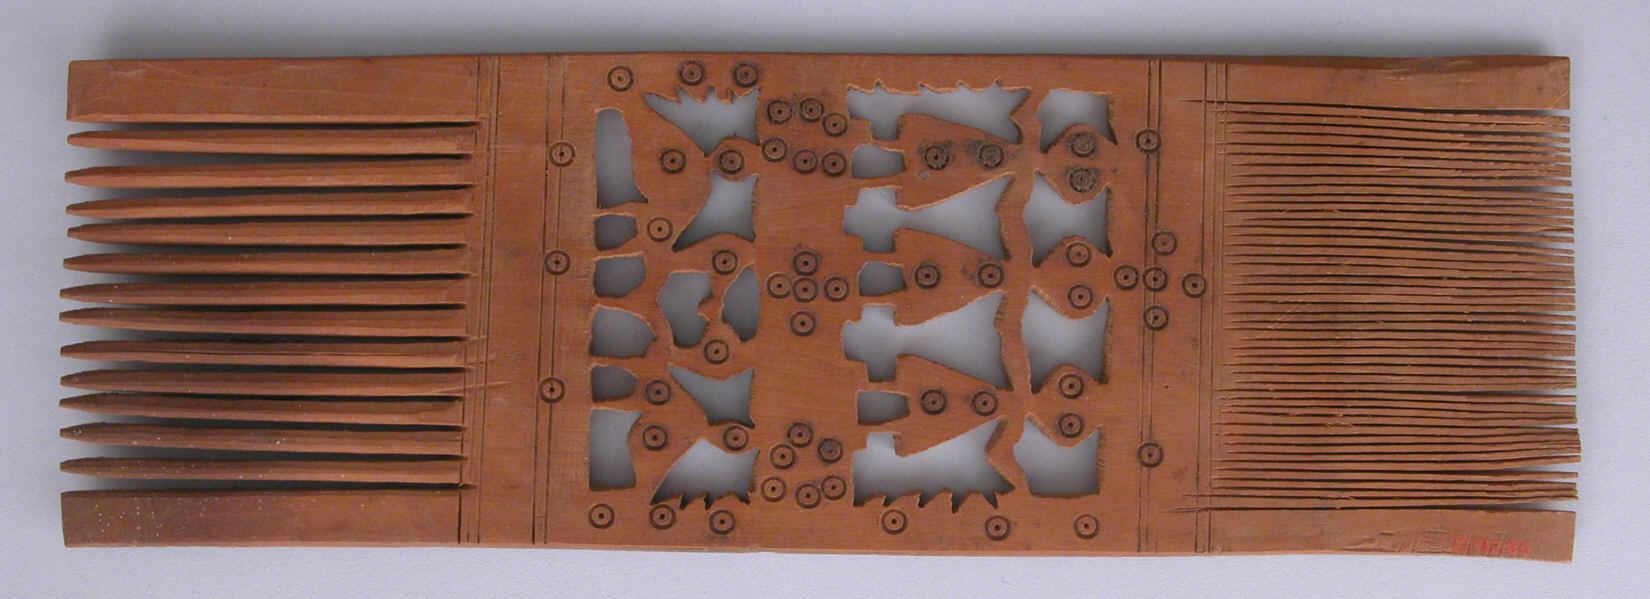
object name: comb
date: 601-800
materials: wood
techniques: carving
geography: egypt